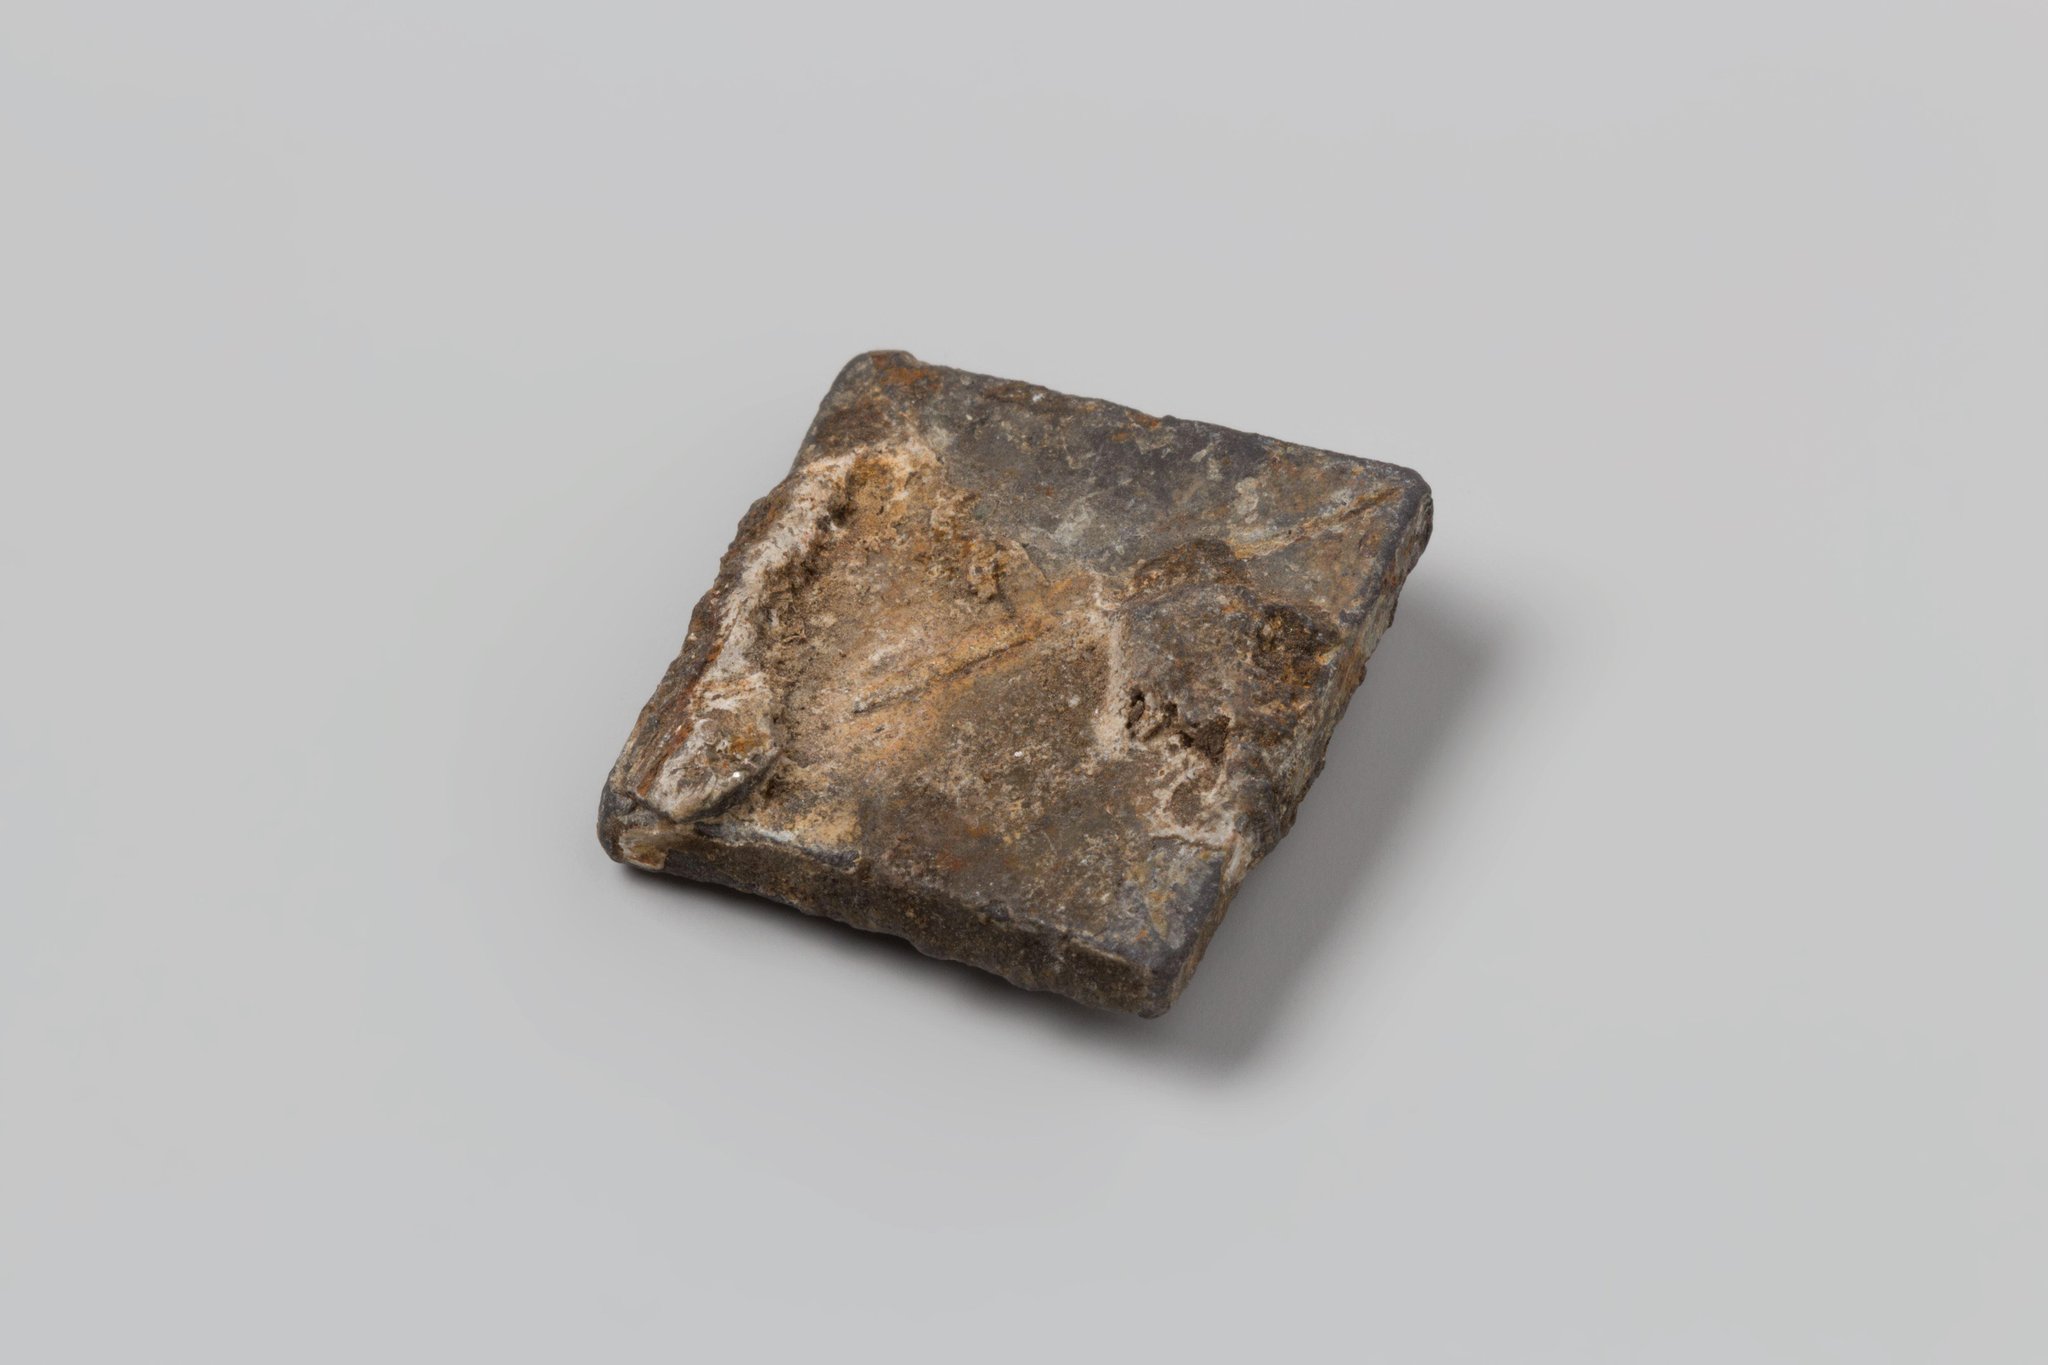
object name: gaming counter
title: Speelpenning uit het wrak van de Oost-Indiëvaarder Hollandia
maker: Anonymous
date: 1700-1743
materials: lead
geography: netherlands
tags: verenigde oostindische compagnie, hollandia (schip), annet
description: Rectangular, square, flat, engraved diagonal cross on one side, game token.